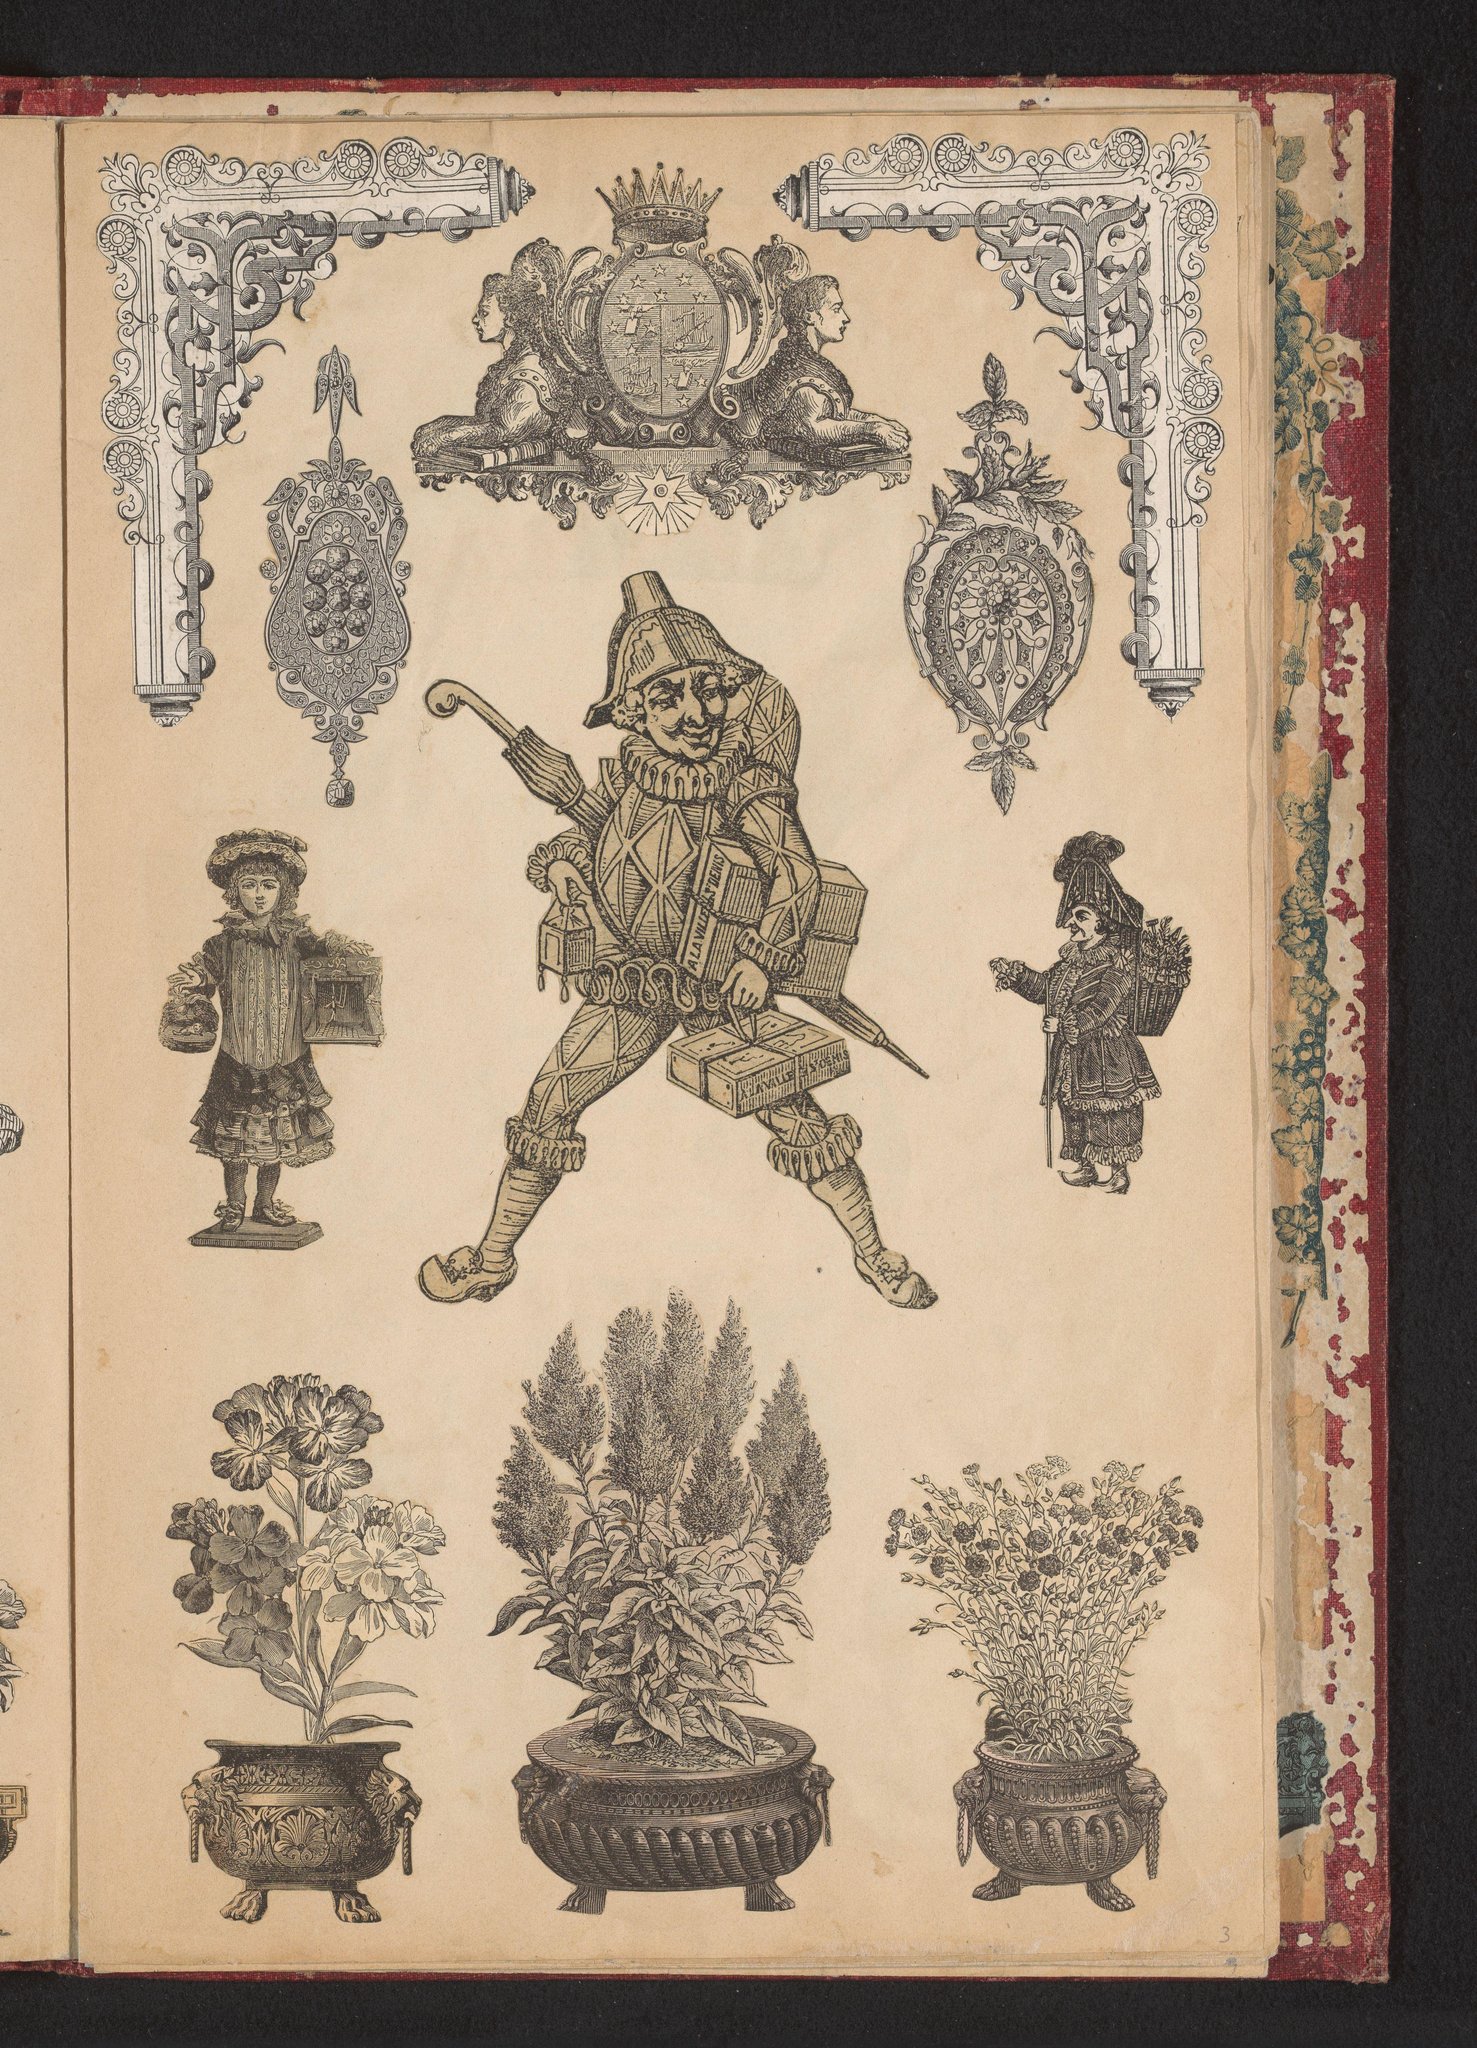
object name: print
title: Collage van uitgeknipte prenten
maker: Anonymous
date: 1870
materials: paper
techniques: engraving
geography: paris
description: Collage van uitgeknipte prenten. Onderdeel van een album met 18 bladen, aan beide zijden beplakt met uitgeknipte prenten, vermoedelijk afkomstig uit 19e-eeuwse tijdschiften.